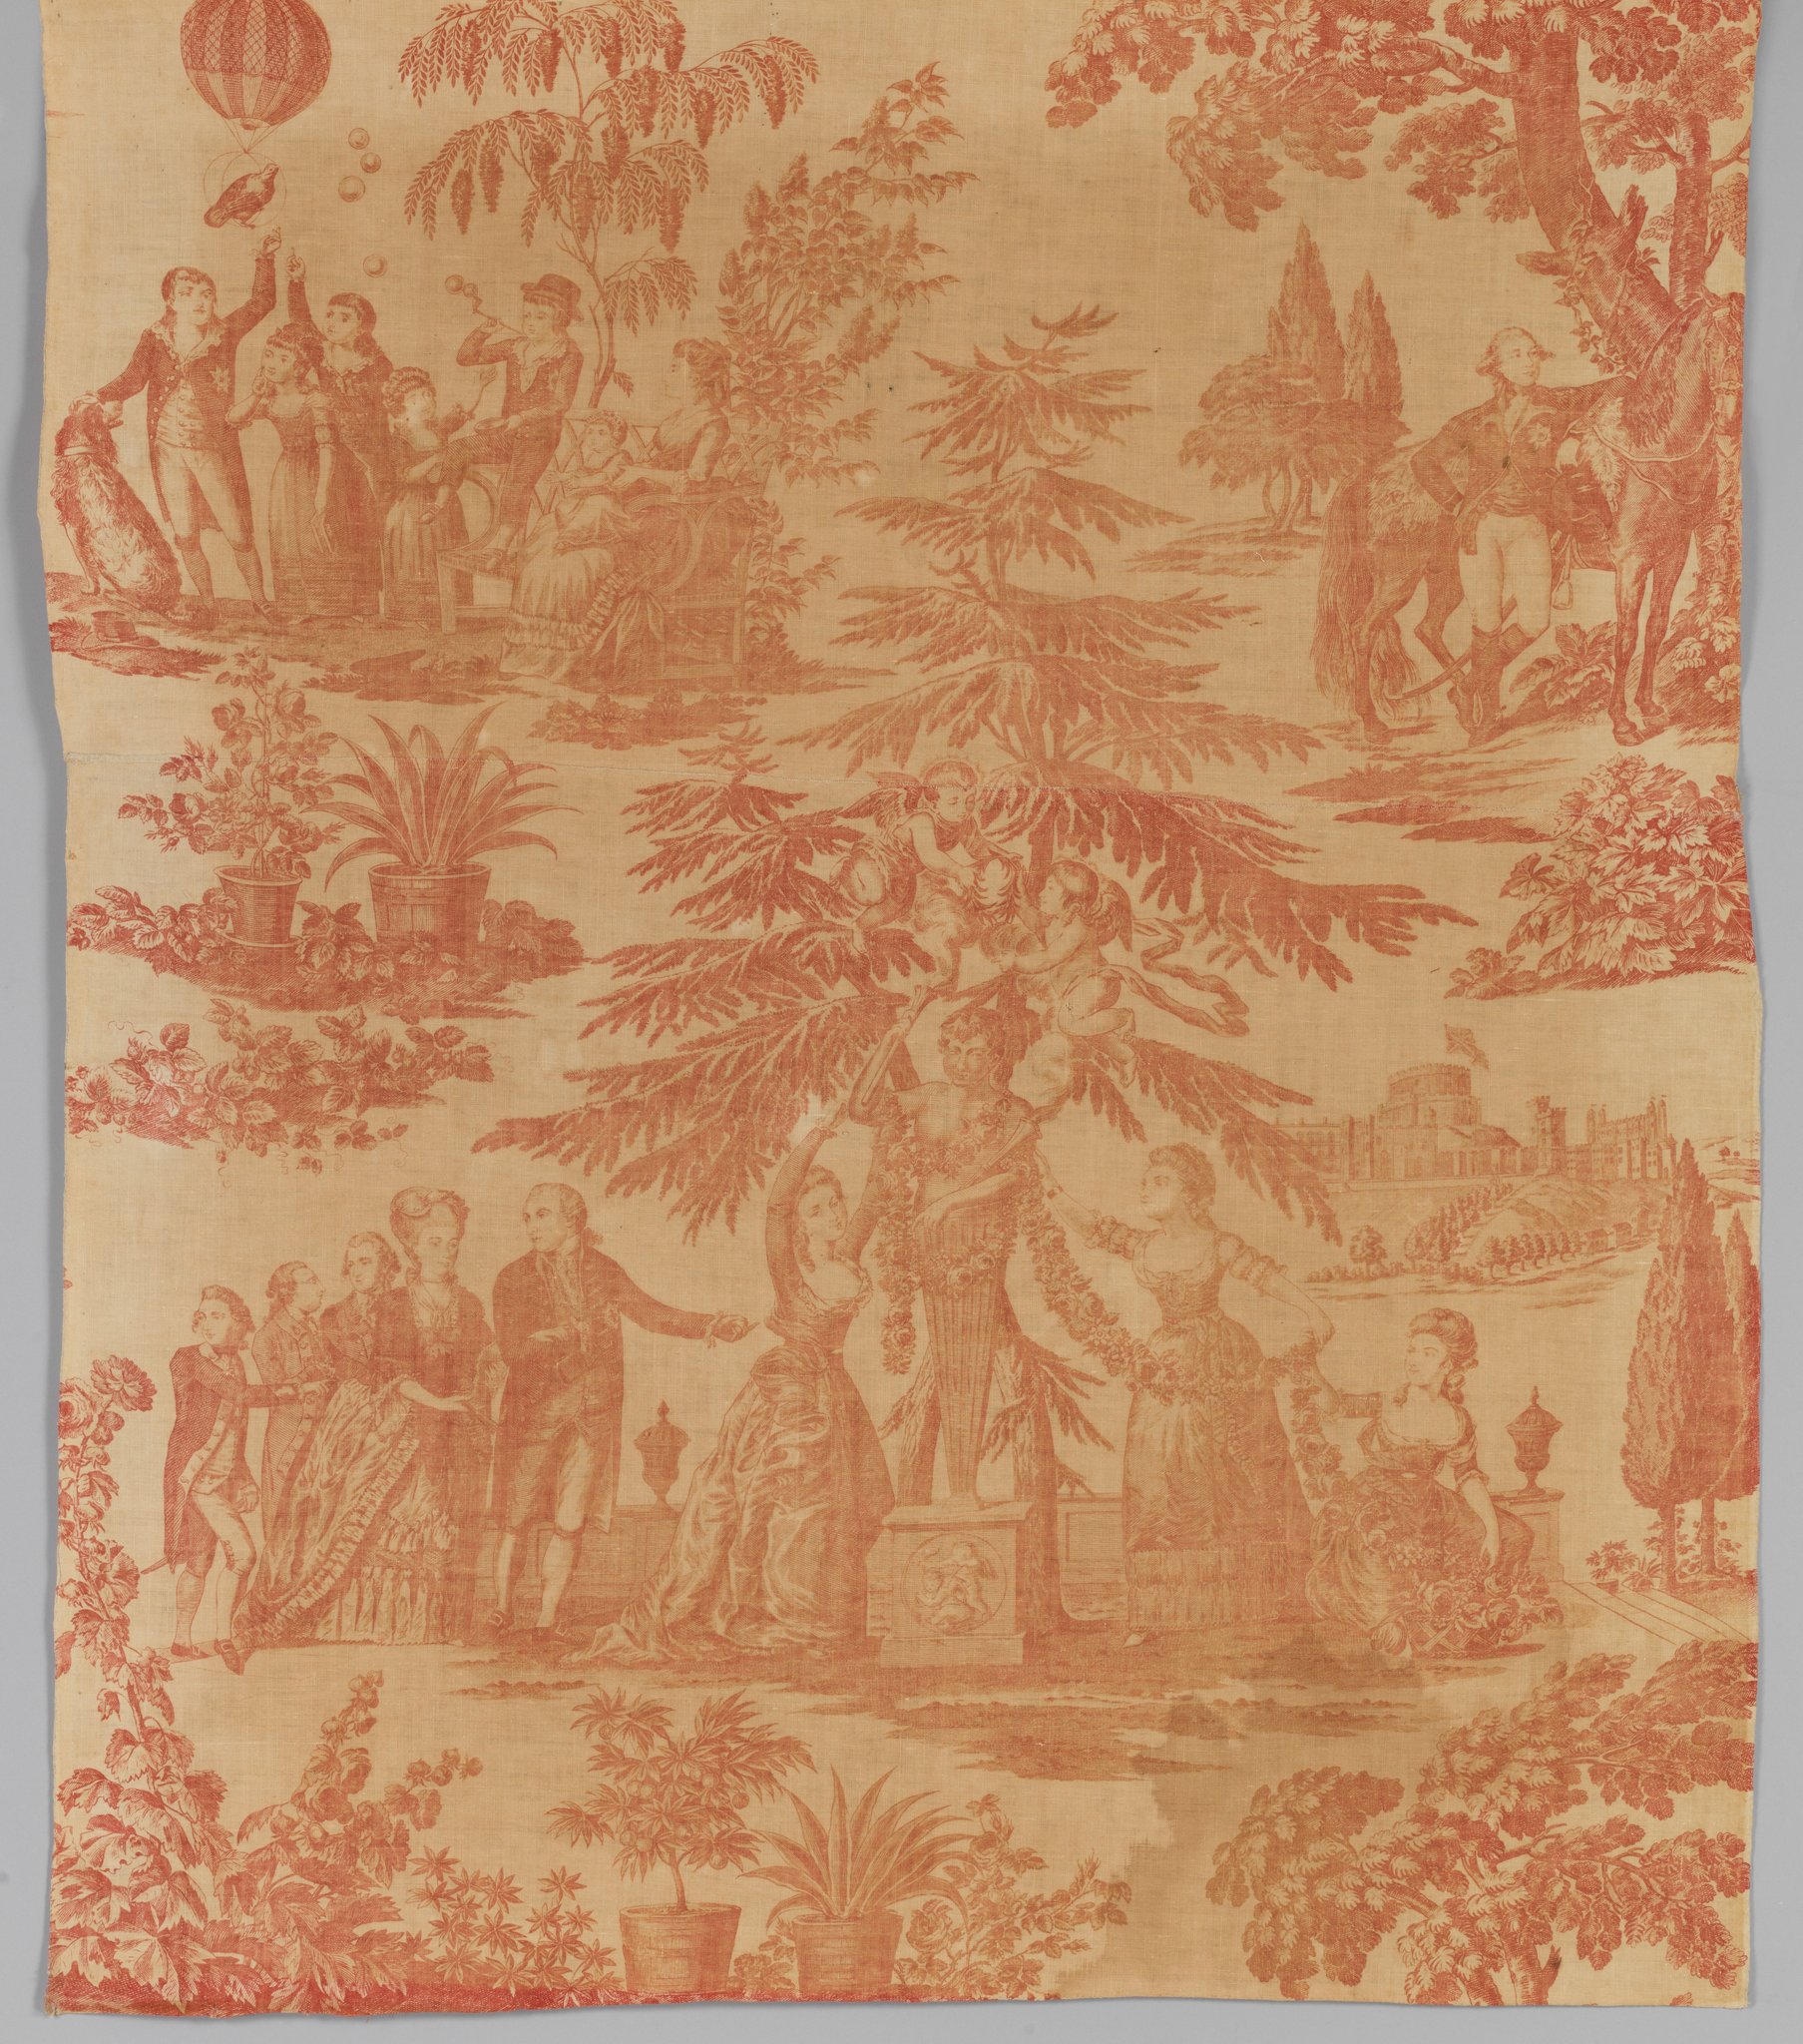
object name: piece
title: Copper plate printed cotton with King George III and his family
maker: j. seymour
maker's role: artist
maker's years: 1725-1825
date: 1785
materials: cotton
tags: kings,dogs,horses,trees,family